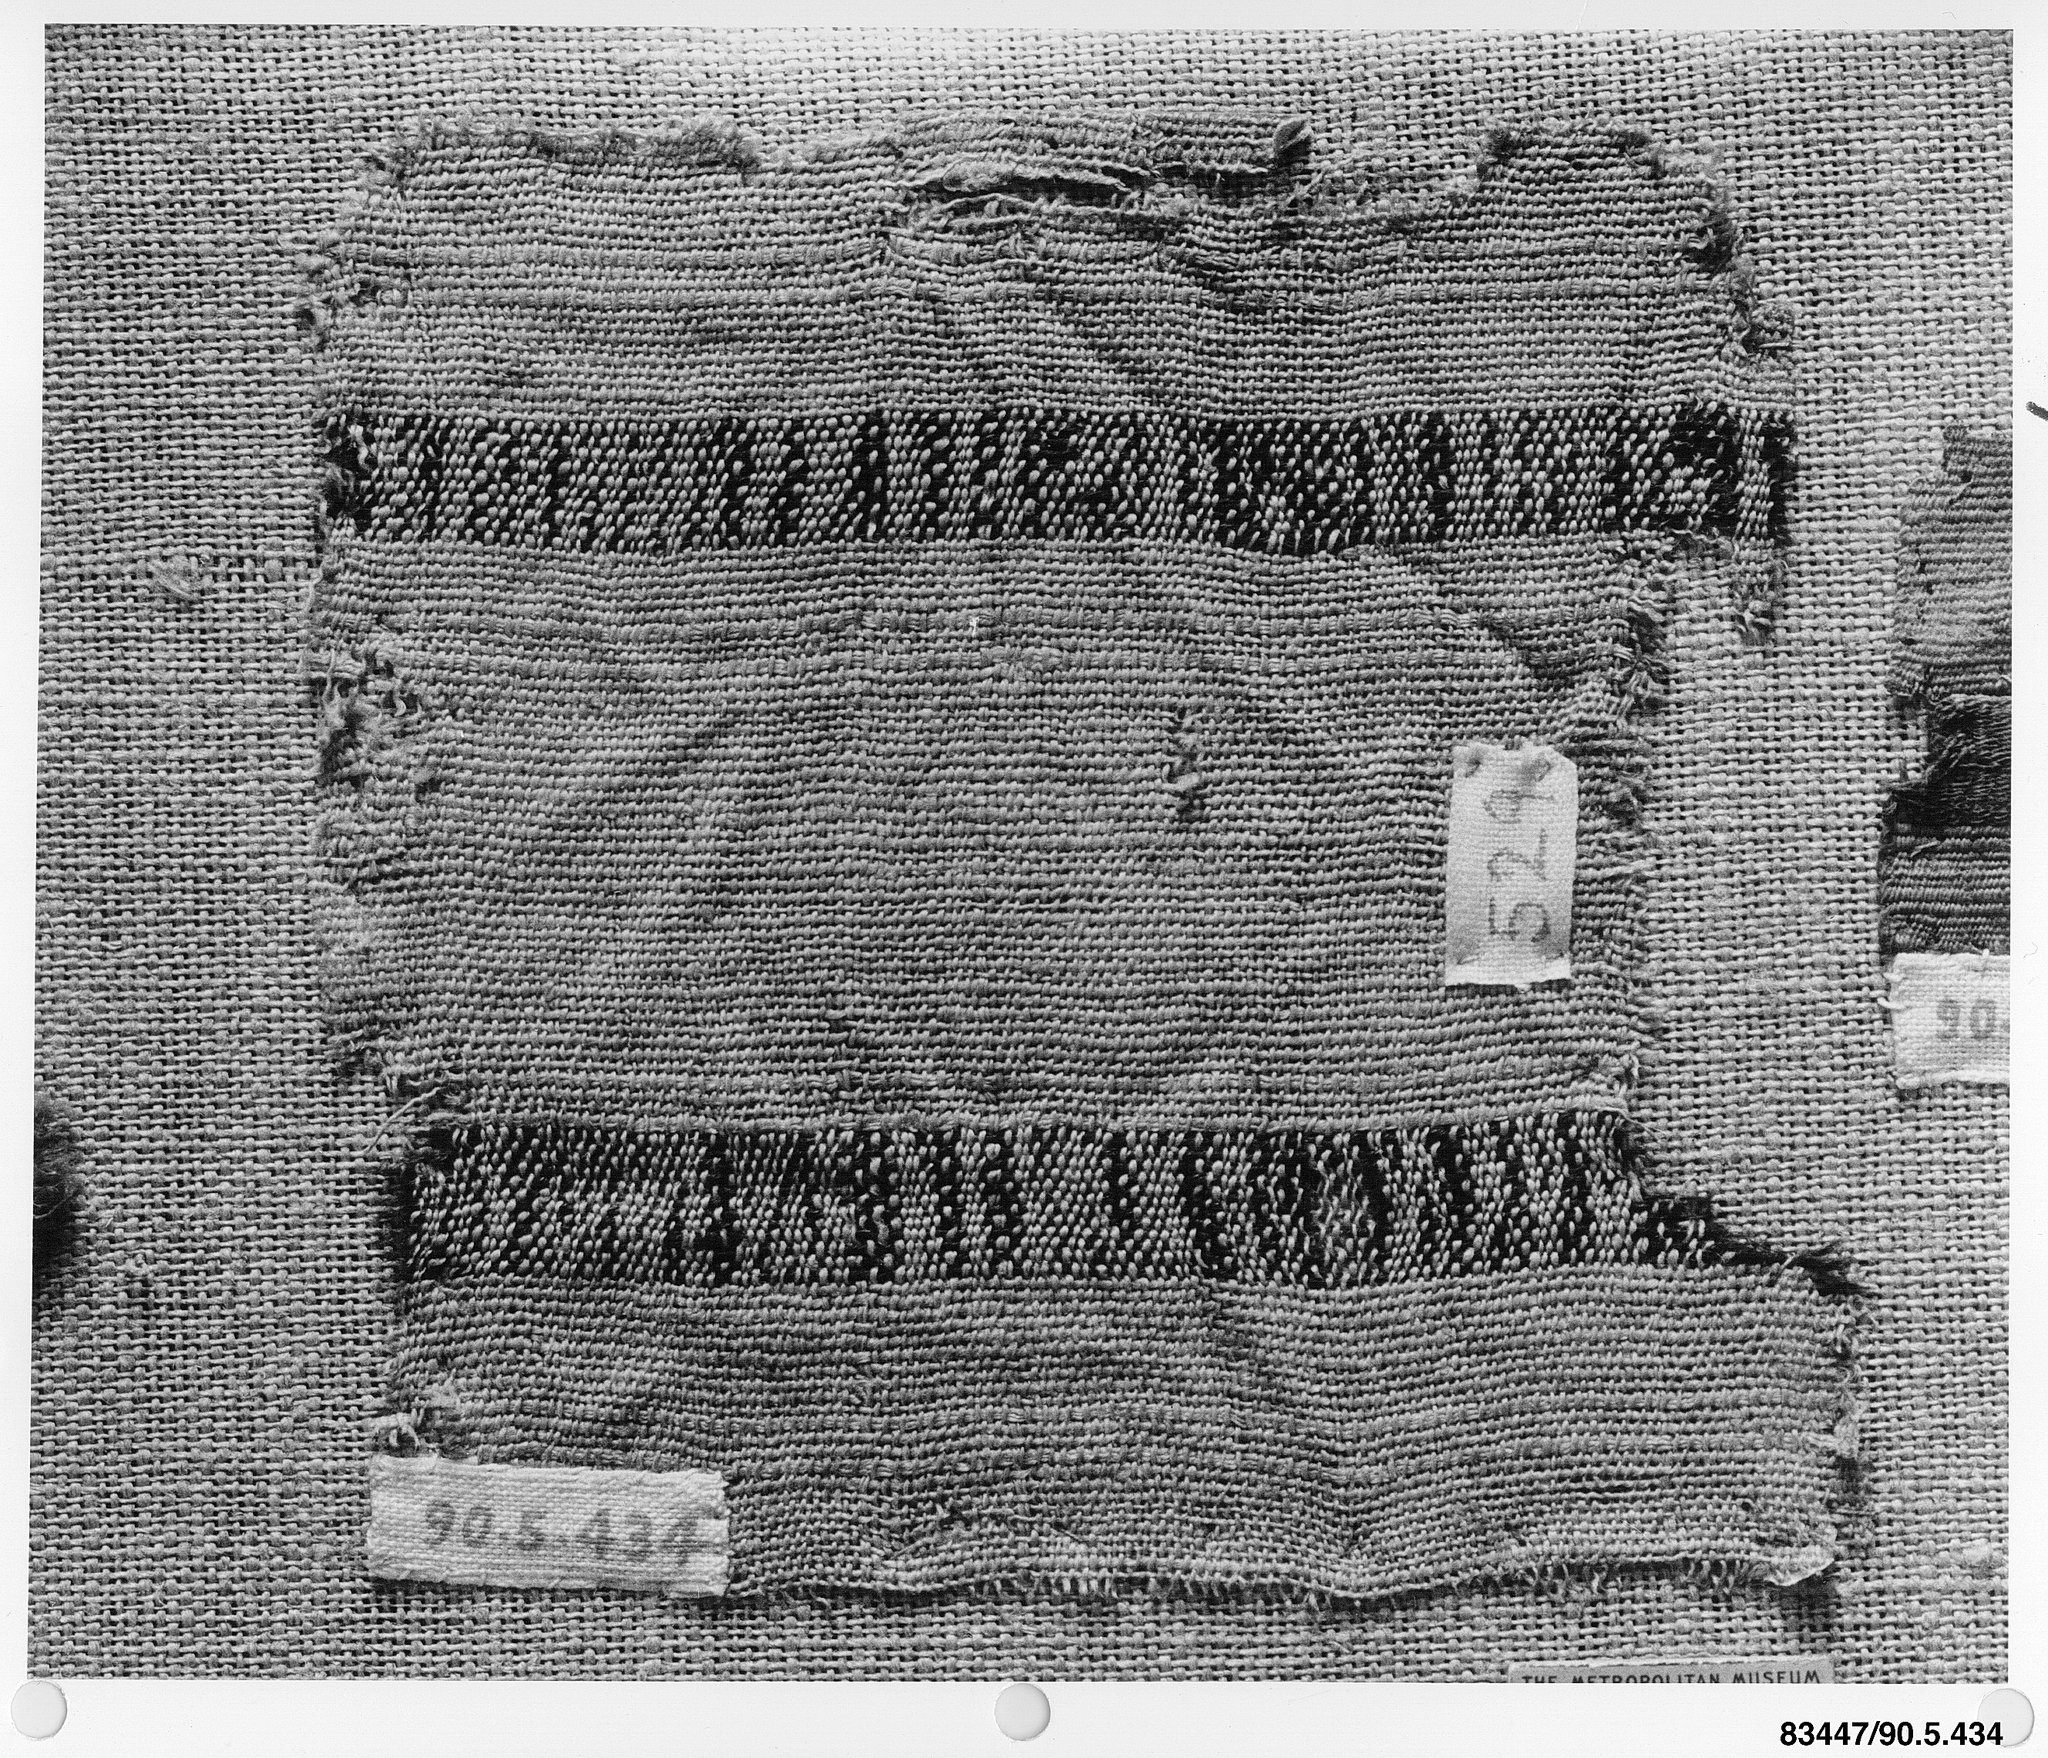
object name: textile fragment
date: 101-300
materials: linen, wool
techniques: weave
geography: egypt